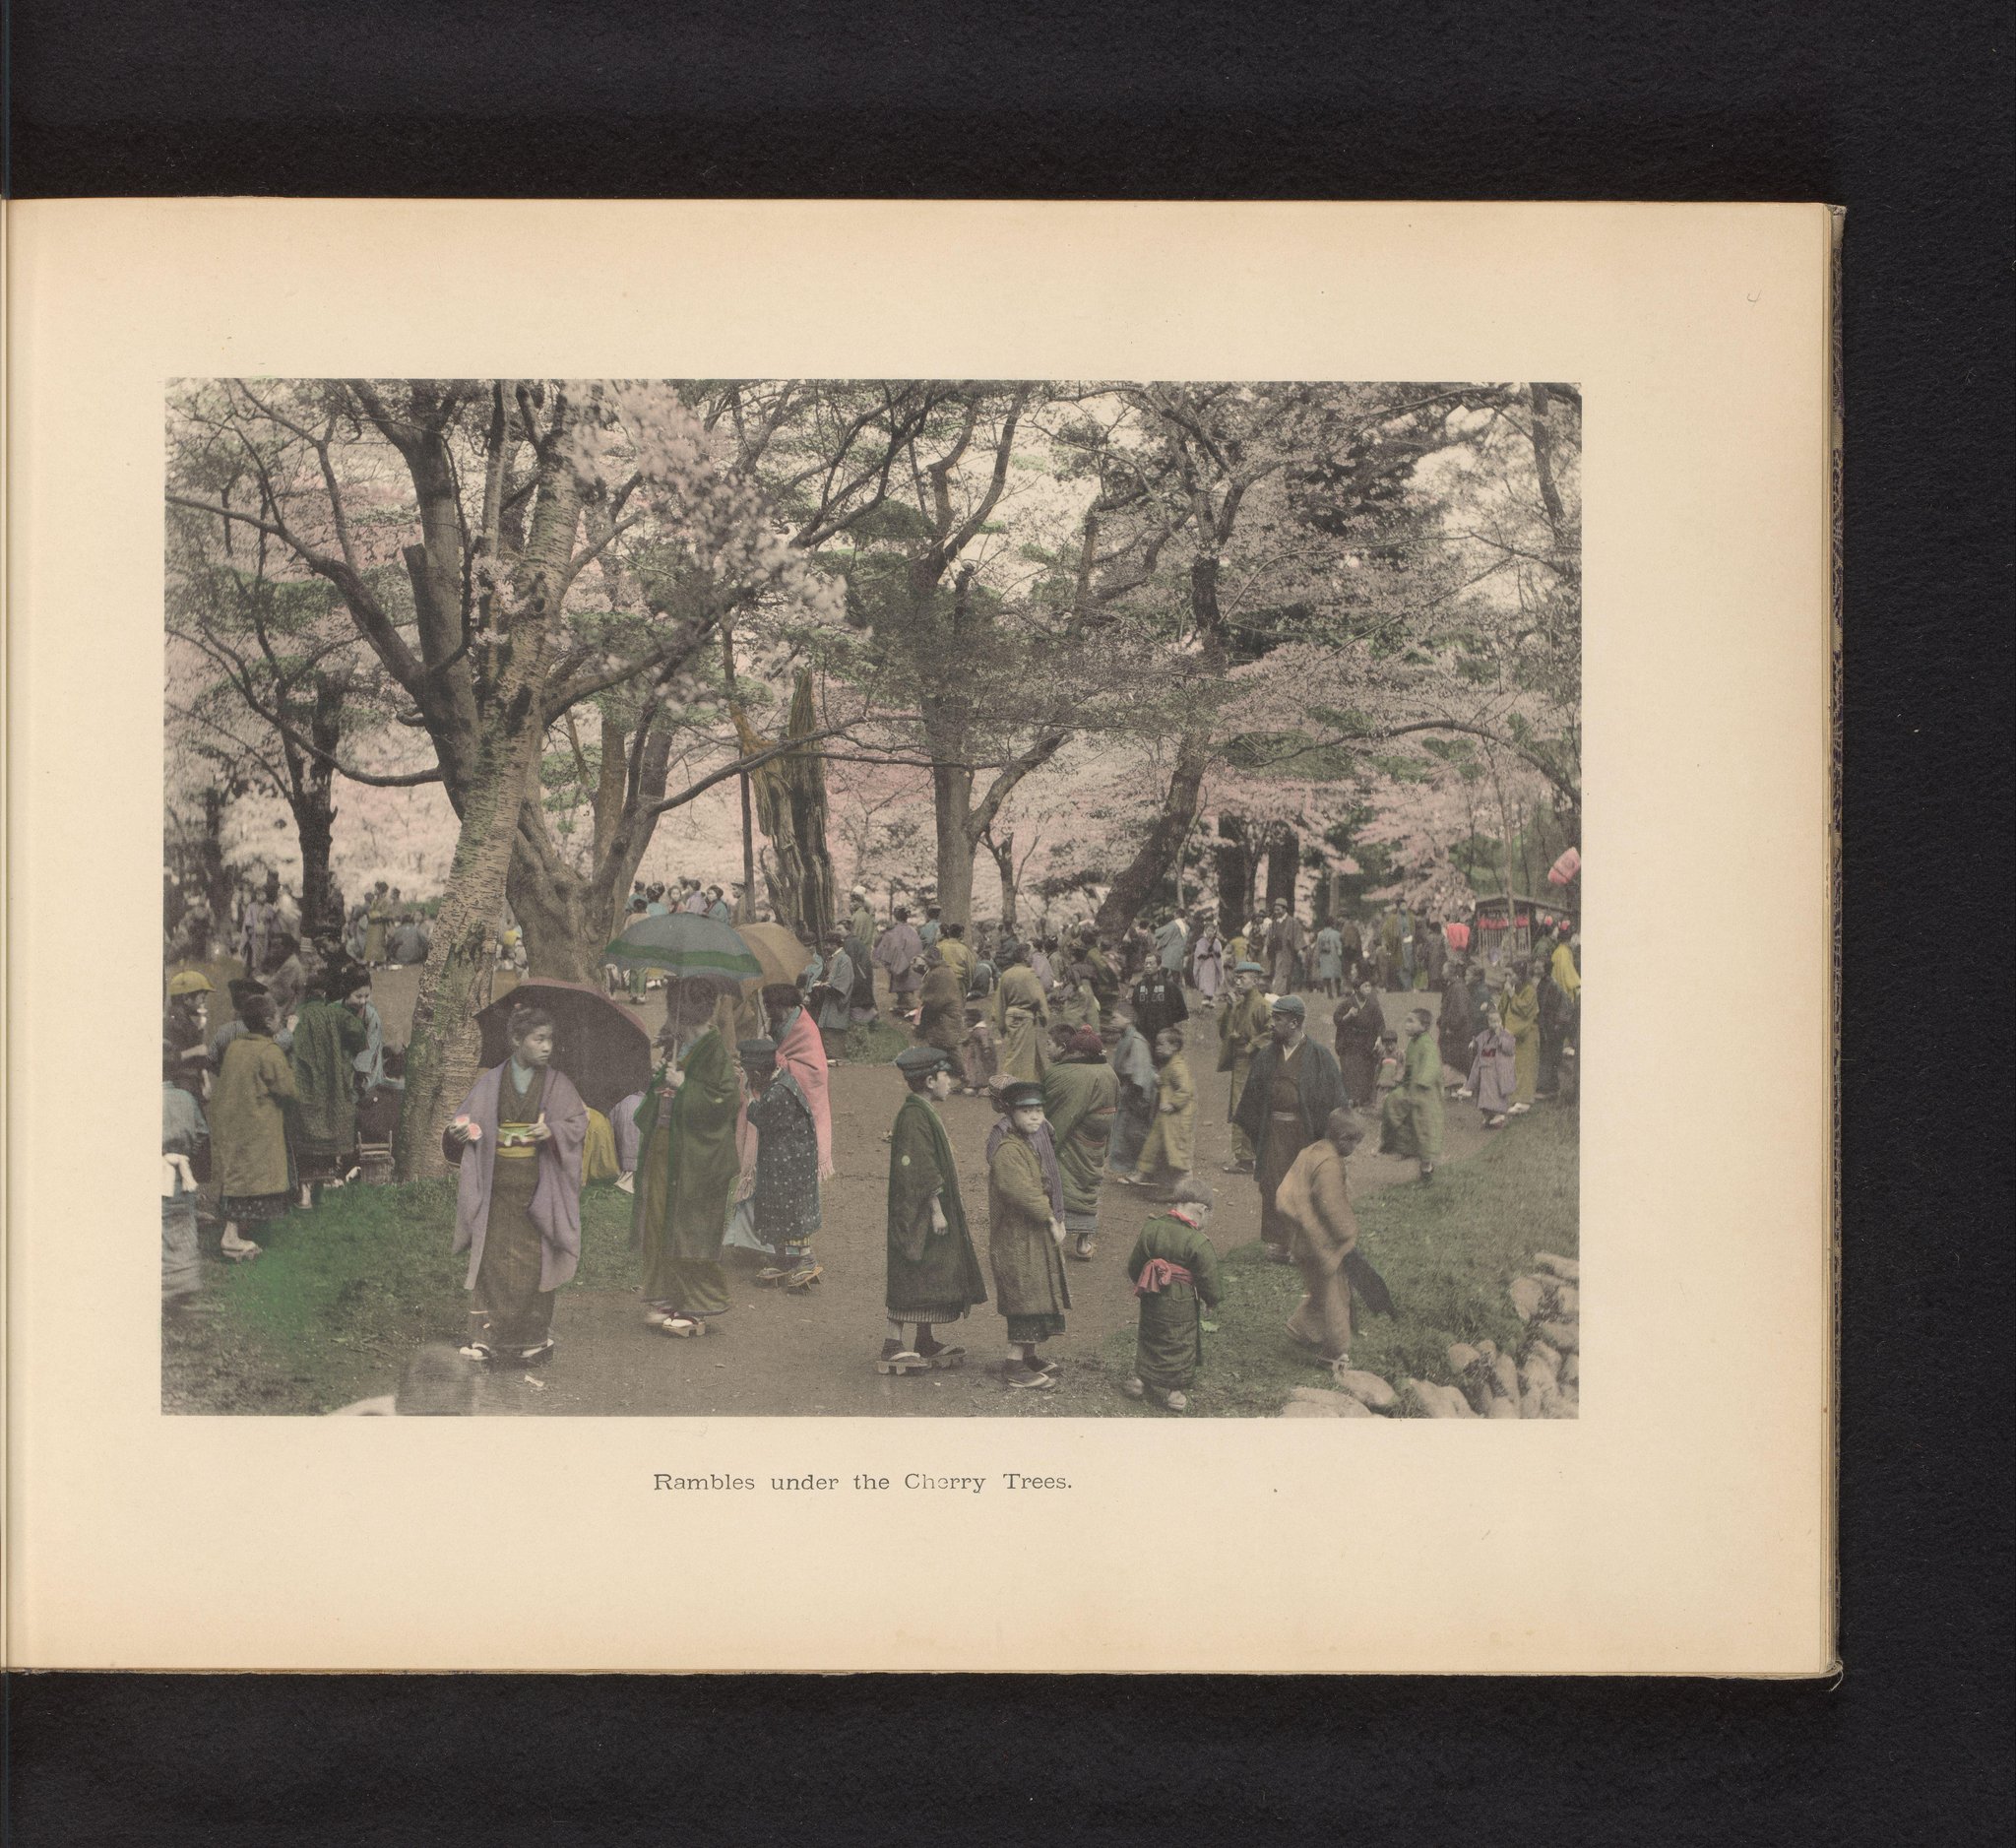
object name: page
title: Rambles under the Cherry Trees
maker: kazumasa ogawa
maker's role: auteur, fotograaf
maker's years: 1860-1929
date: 1892-1897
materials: paper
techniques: photograph, hand coloring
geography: uenopark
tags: park, trees: cherry-tree, adult woman (+ more than eight persons), adult man (+ more than eight persons)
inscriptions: number: ‘4’